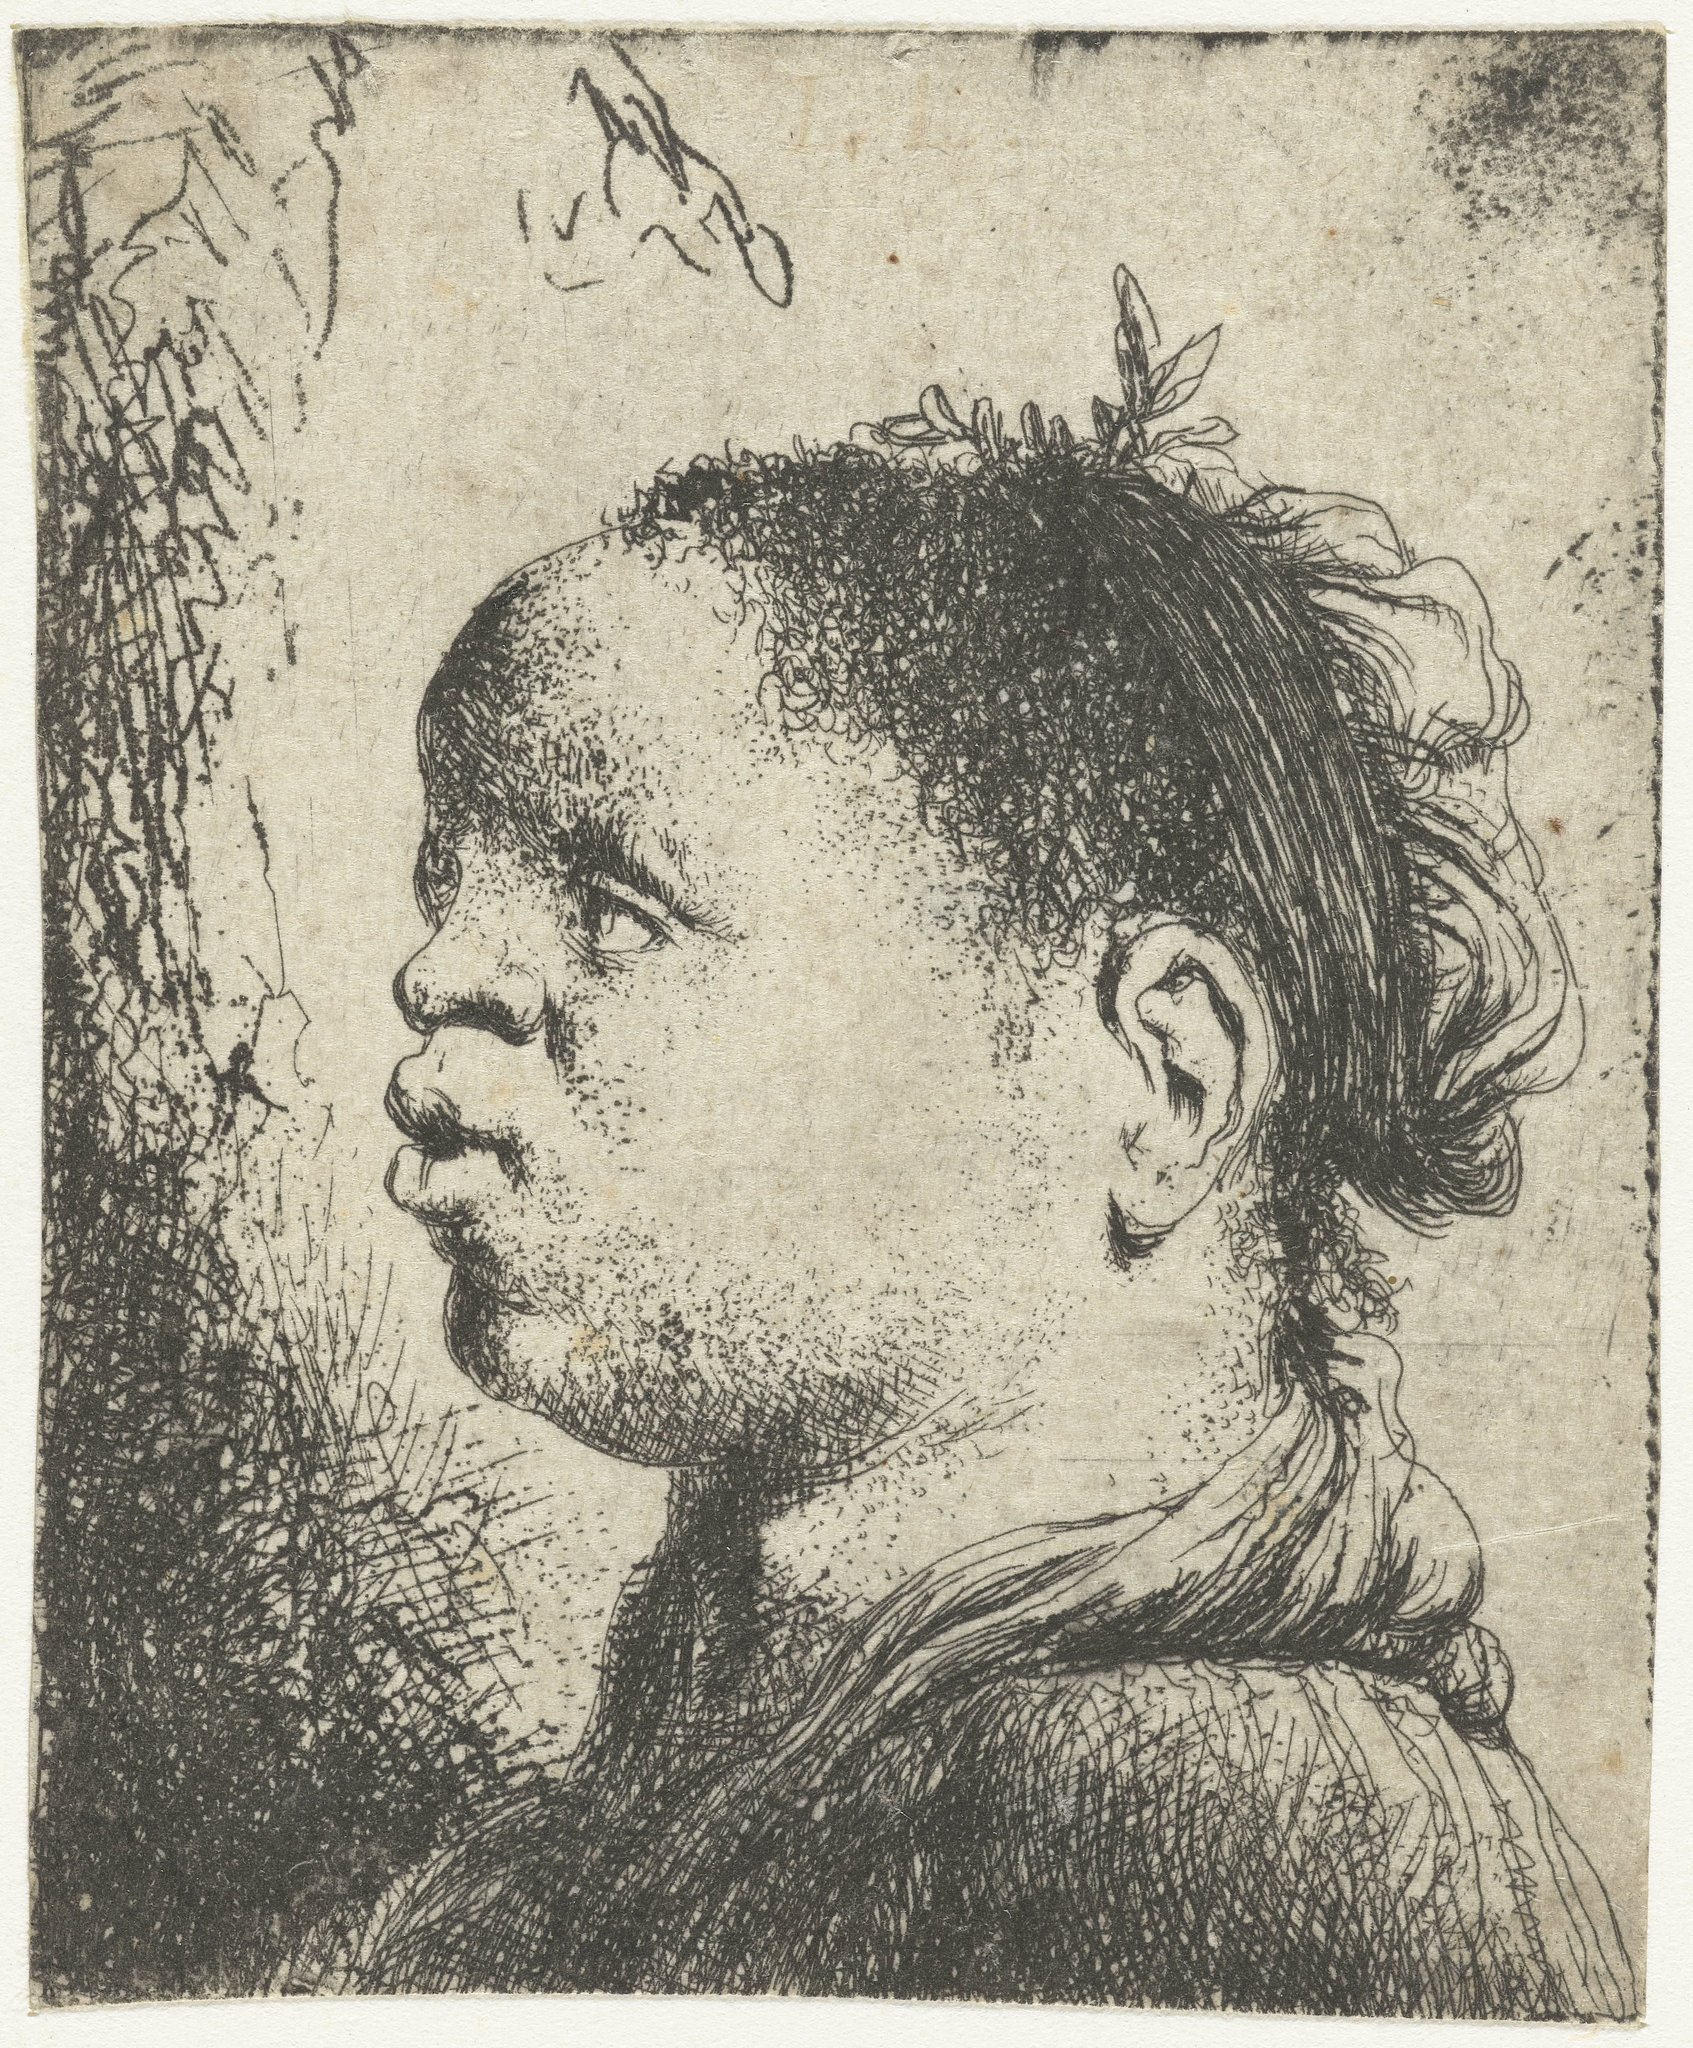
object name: print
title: Borstbeeld van een zwarte vrouw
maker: jan lievens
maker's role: draughtsman, painter, print maker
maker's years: 1607-1674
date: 1625-1674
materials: paper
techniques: etching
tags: female sex; woman, africans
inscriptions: collector's mark: Lugt 2228a, collector's mark:, collector's mark: Lugt 1092a, collector's mark: Lugt 2760, collector's mark: ‘Dr. Herweg’